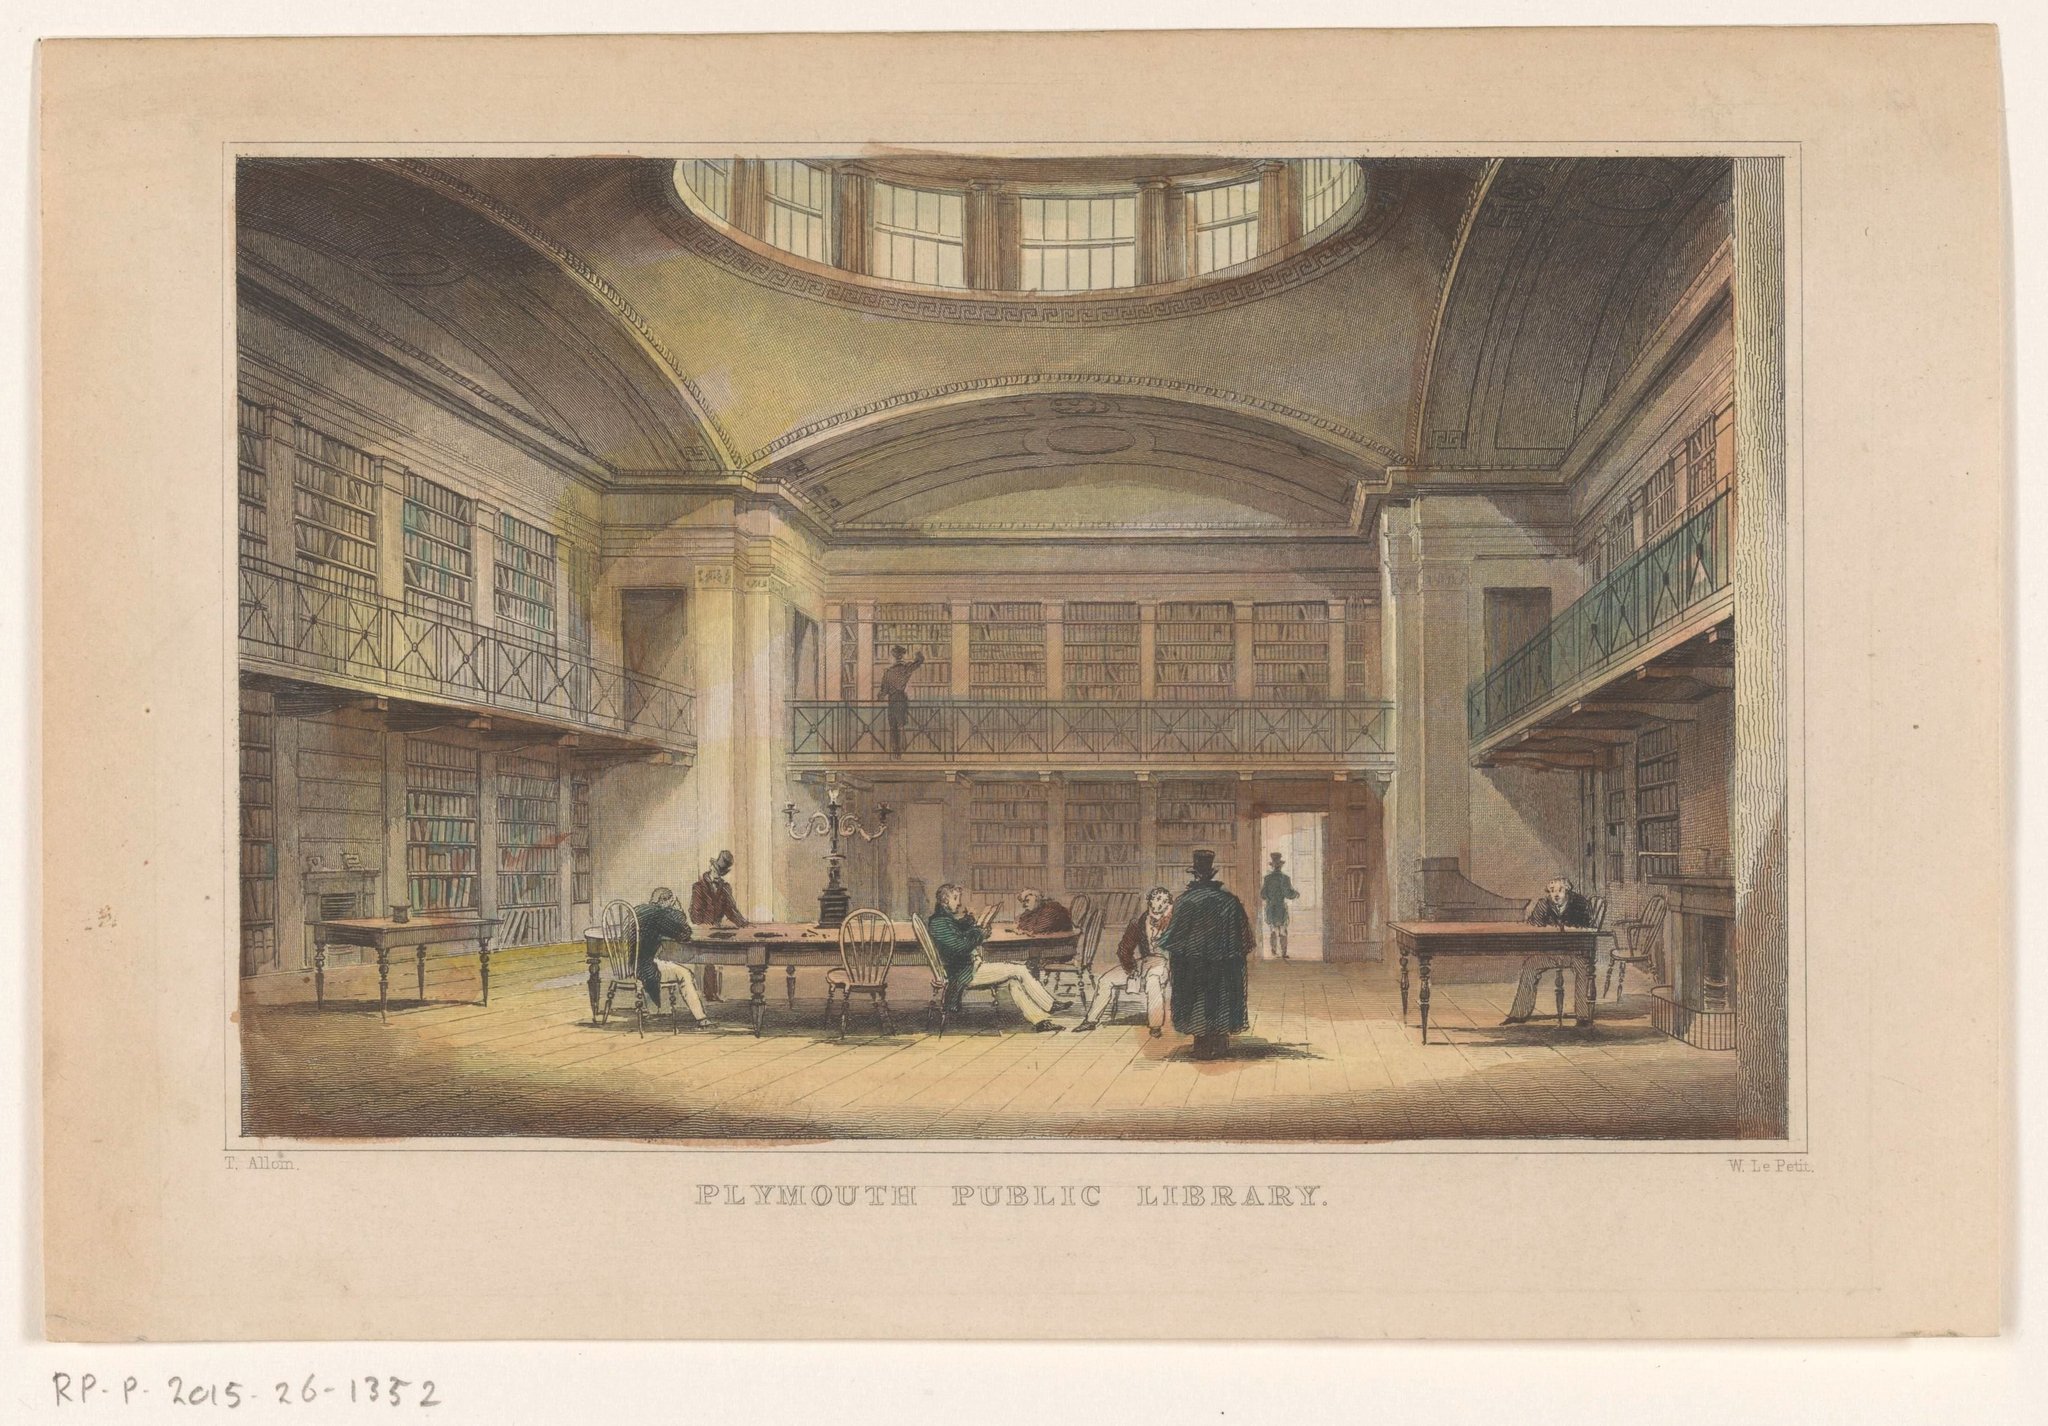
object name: print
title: Plymouth Public Library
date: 1832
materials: paper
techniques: etching, hand coloring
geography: london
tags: public library, plymouth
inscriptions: collector's mark: Lugt 4779, collector's mark: Lugt 2228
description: Prent ook gebruikt in: Devonshire & Cornwall, illustrated from original drawings by Thomas Allom. Londen: H. Fischer & Co., 1832.